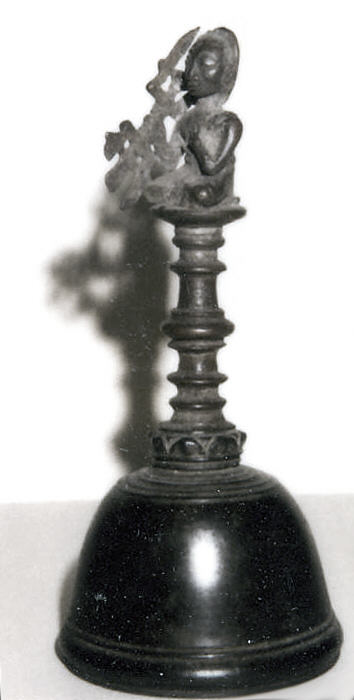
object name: bell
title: Bell with Seated Male Holding Vajra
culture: indonesian, javanese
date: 901-1100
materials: bronze